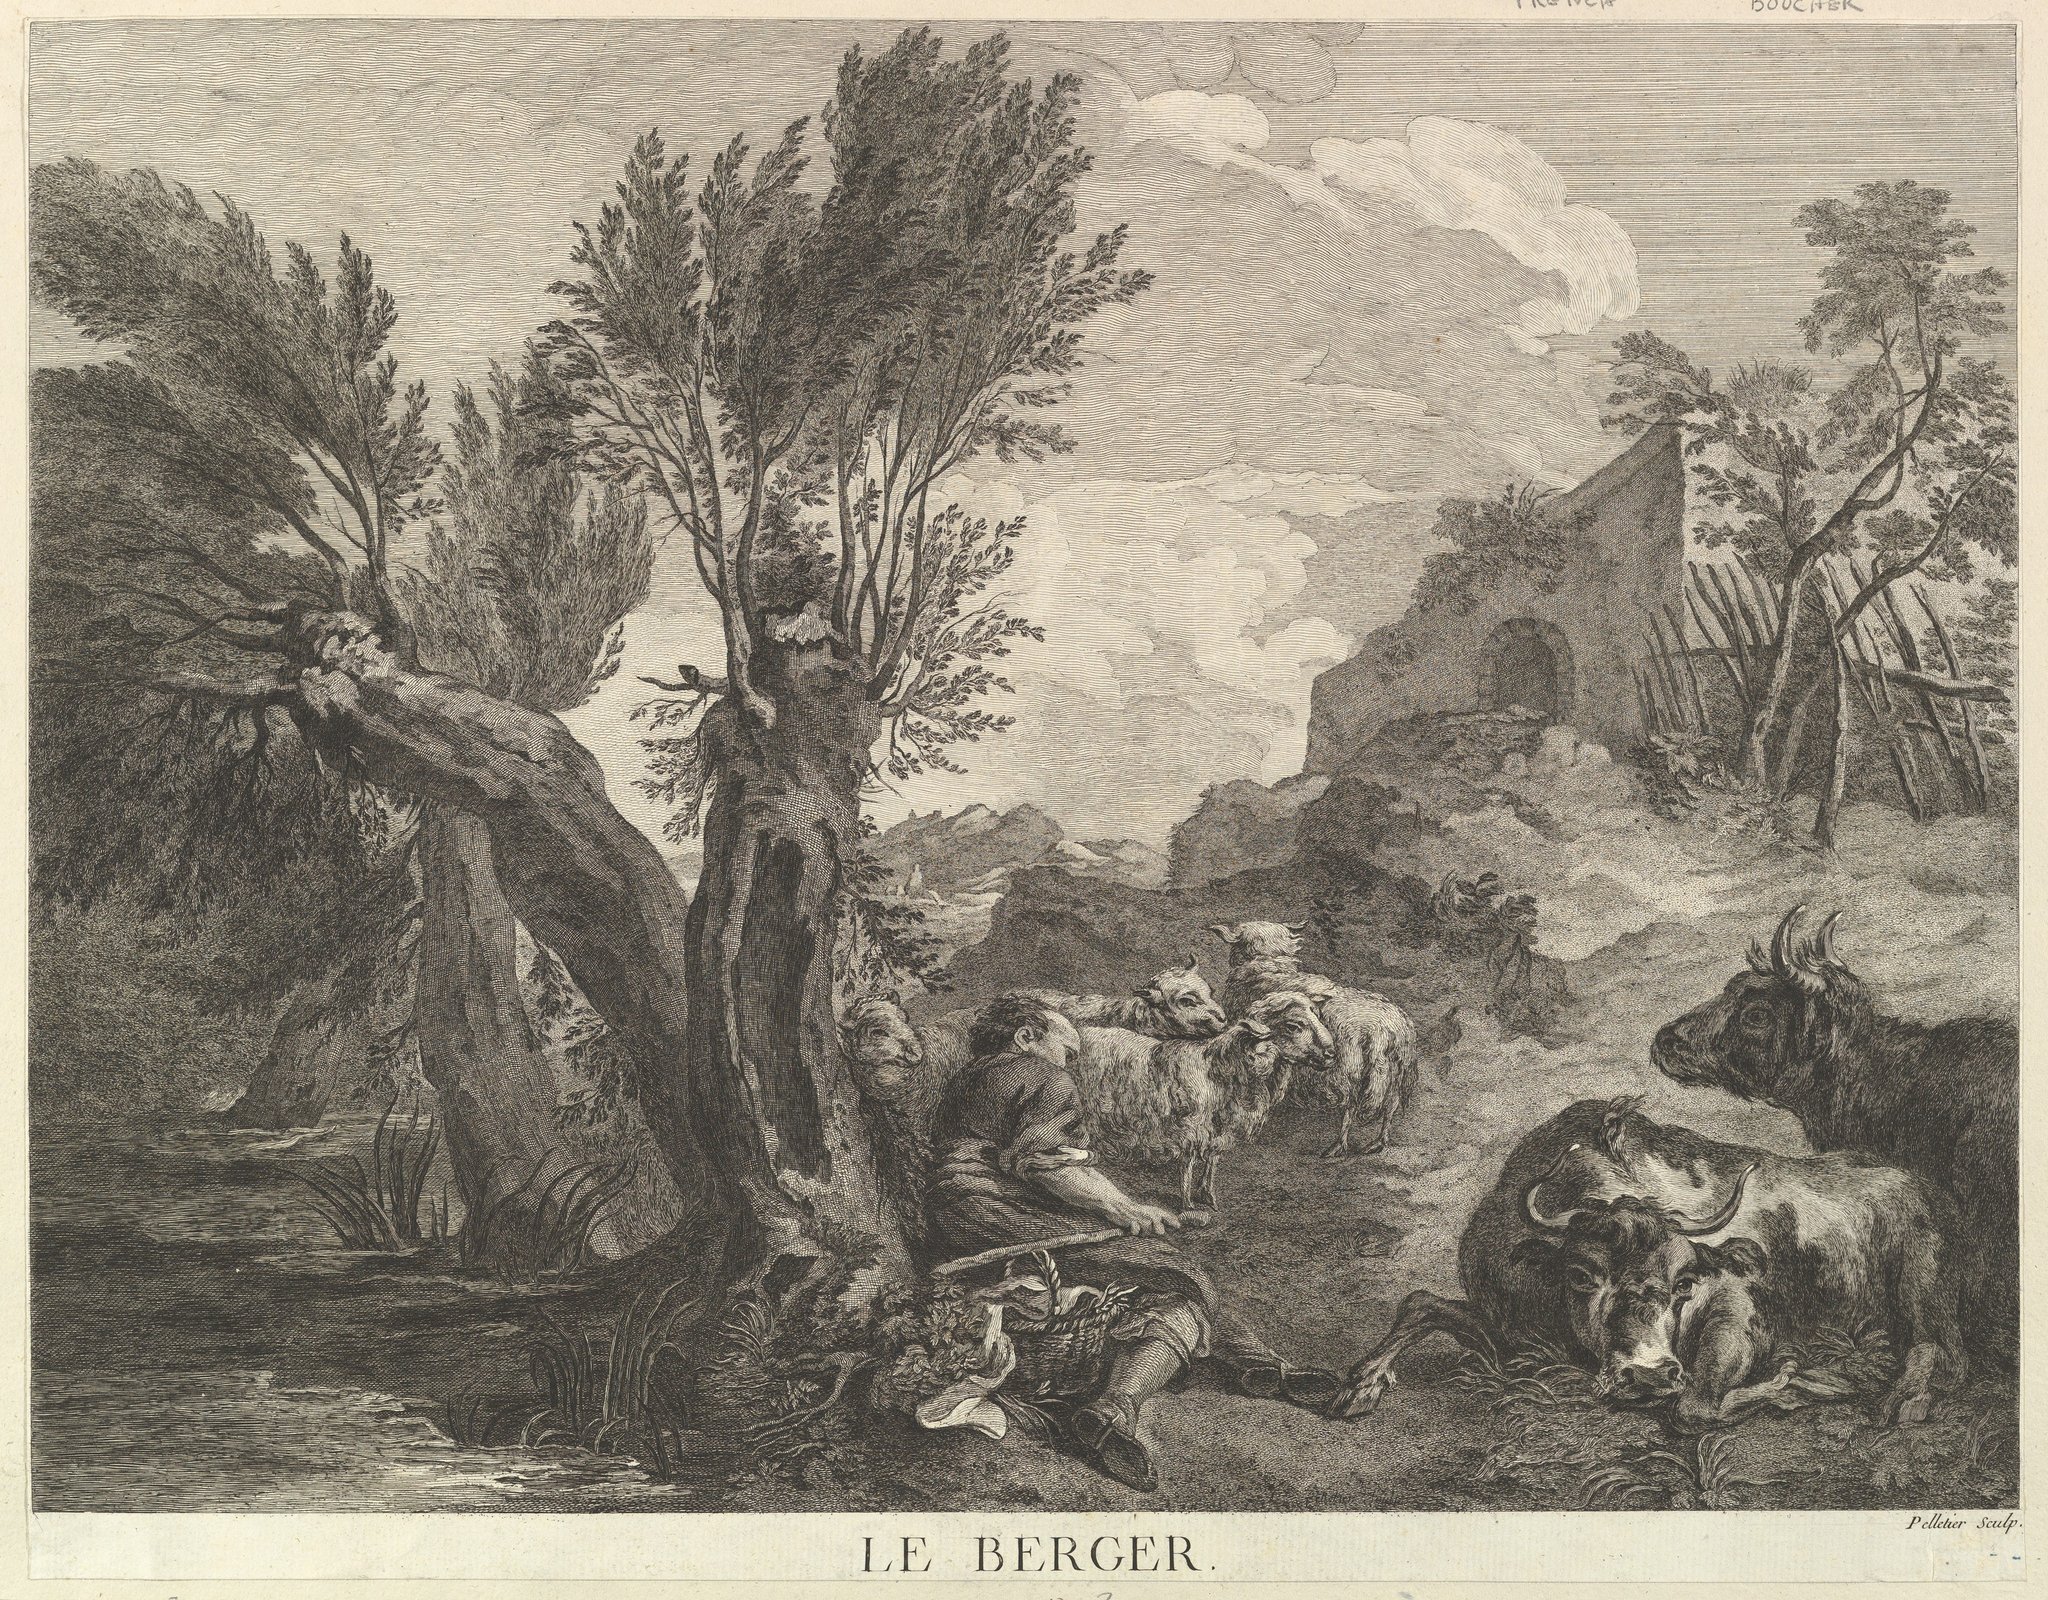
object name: print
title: The Shepherd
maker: jean pelletier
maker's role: artist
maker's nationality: french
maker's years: 1736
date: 1736-1800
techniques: engraving, etching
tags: men,cows,sheep,trees,shepherds